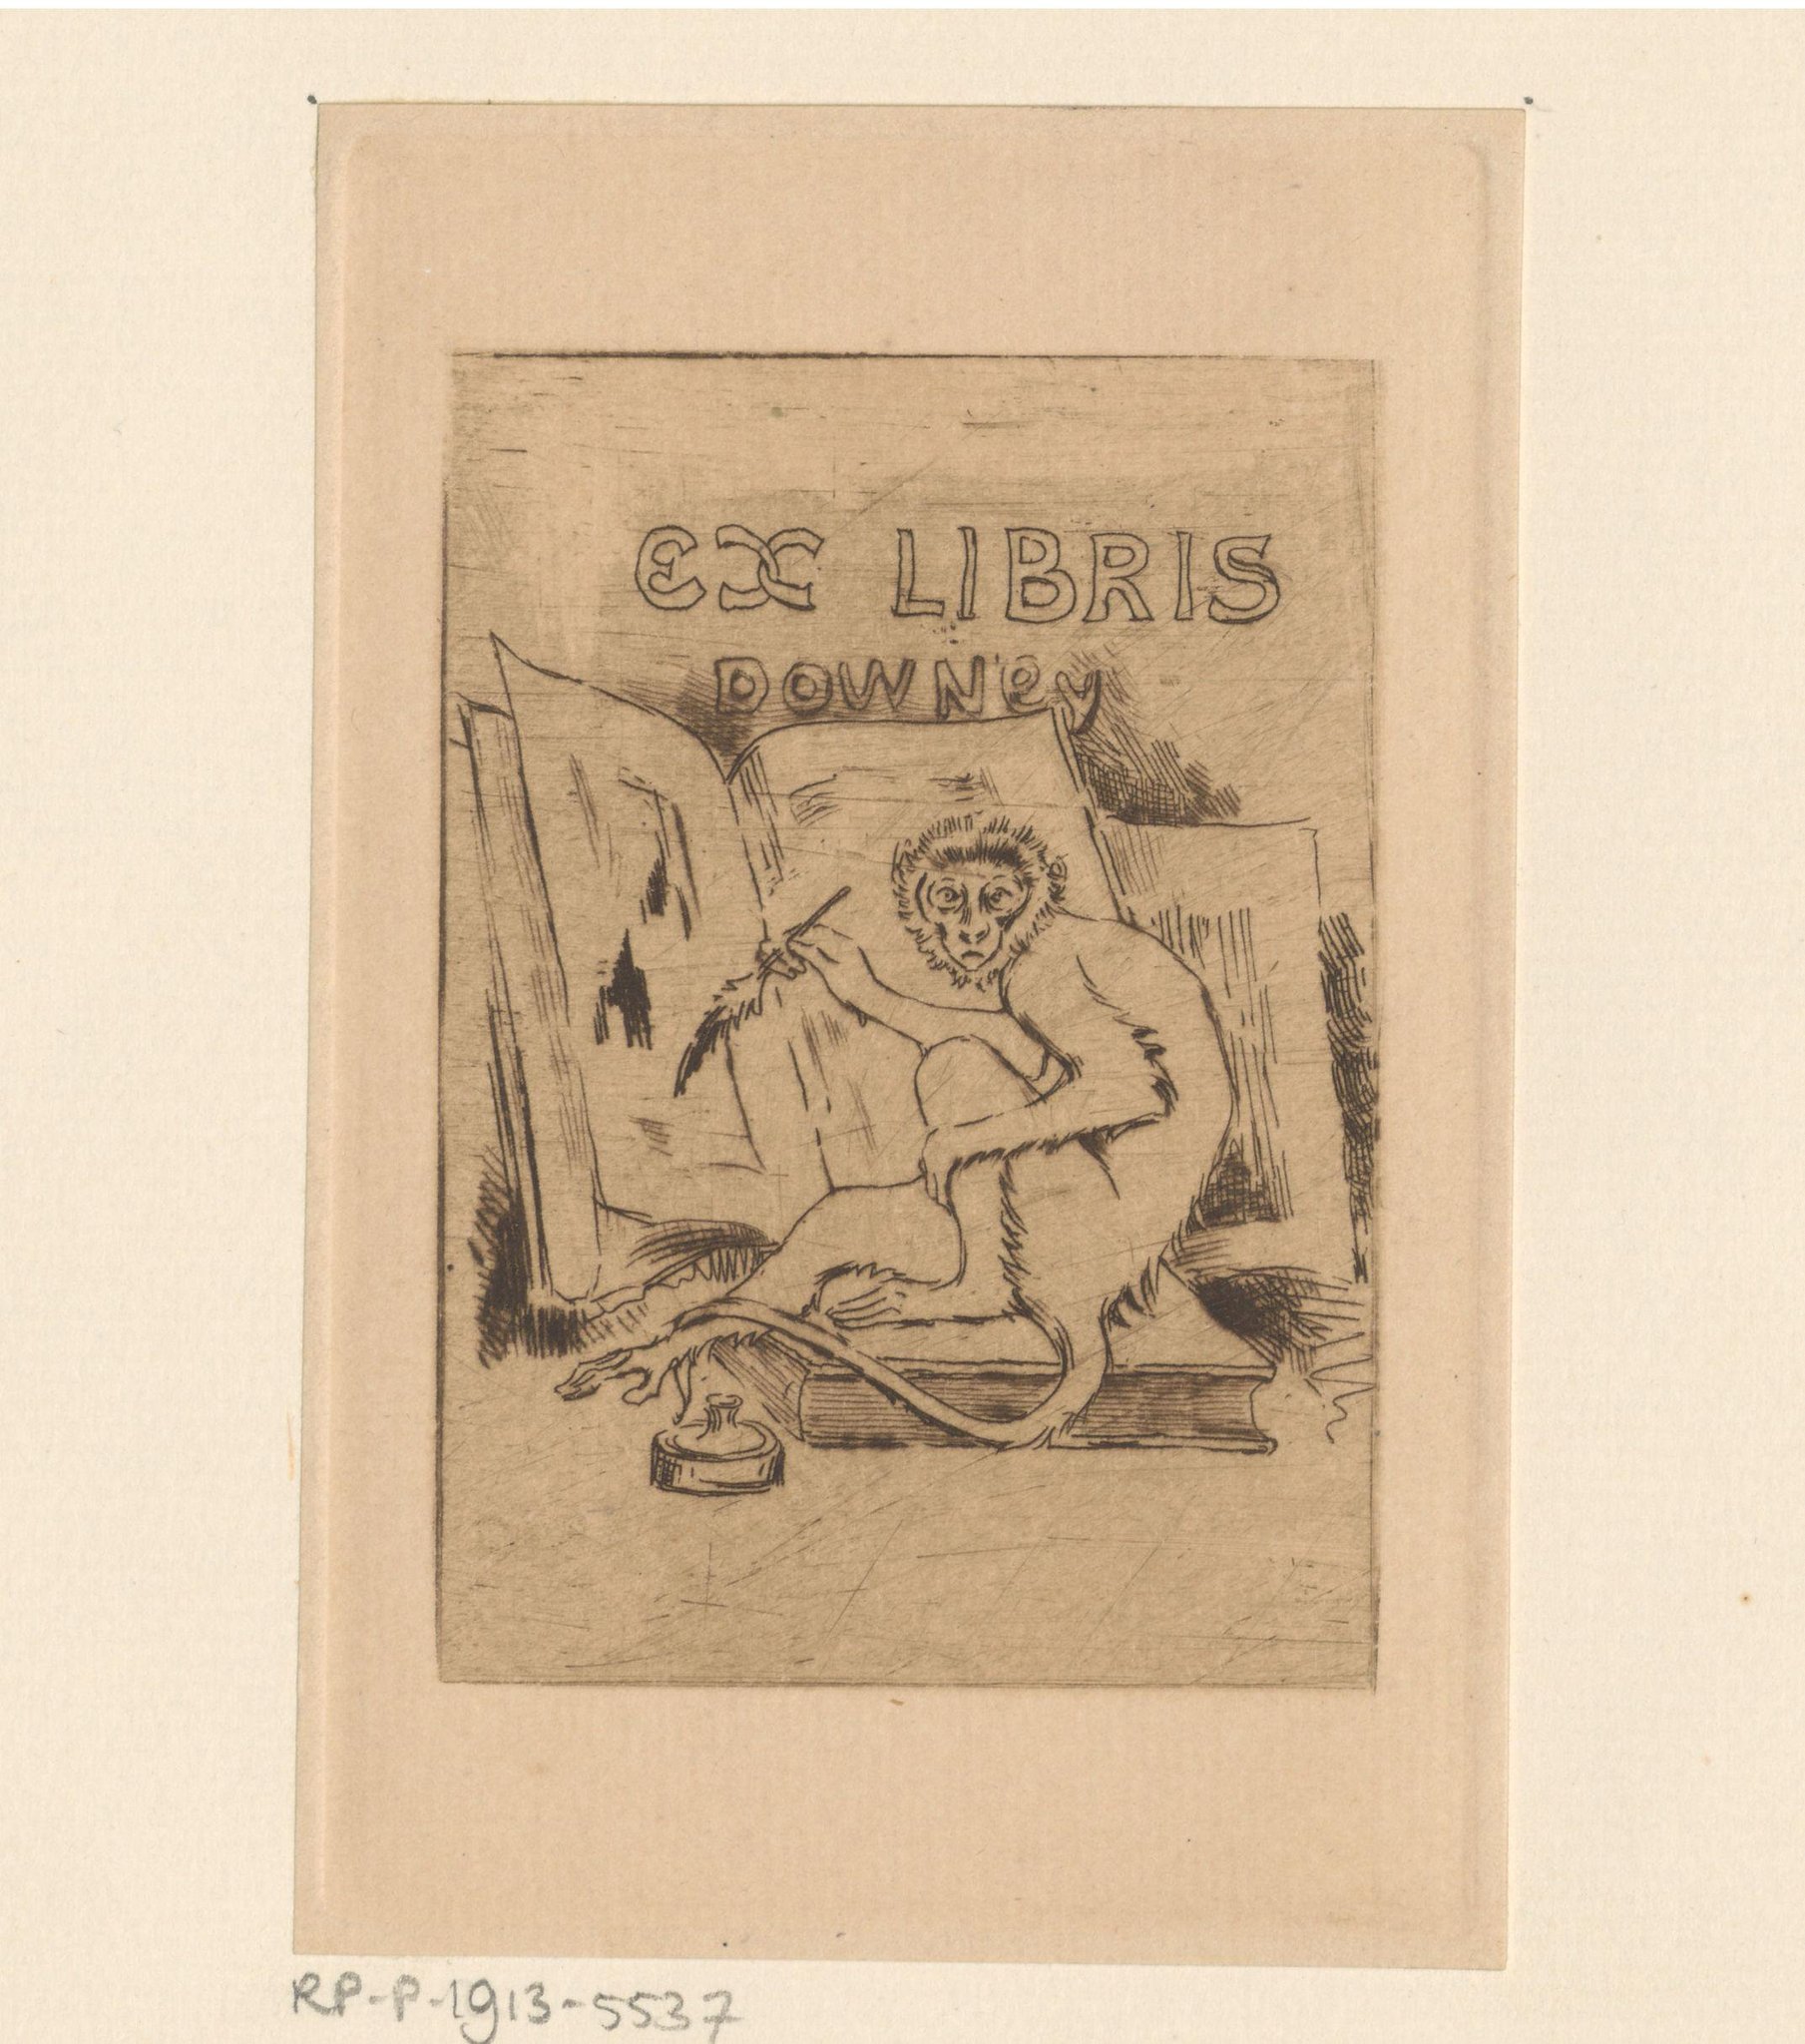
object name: bookplate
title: Ex libris van Downey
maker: j.e. sylvestre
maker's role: print maker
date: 1880-1913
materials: paper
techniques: drypoint, etching, intaglio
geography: france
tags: quill, monkeys, apes, book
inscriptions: collector's mark: Lugt 2233, collector's mark: Lugt 2760